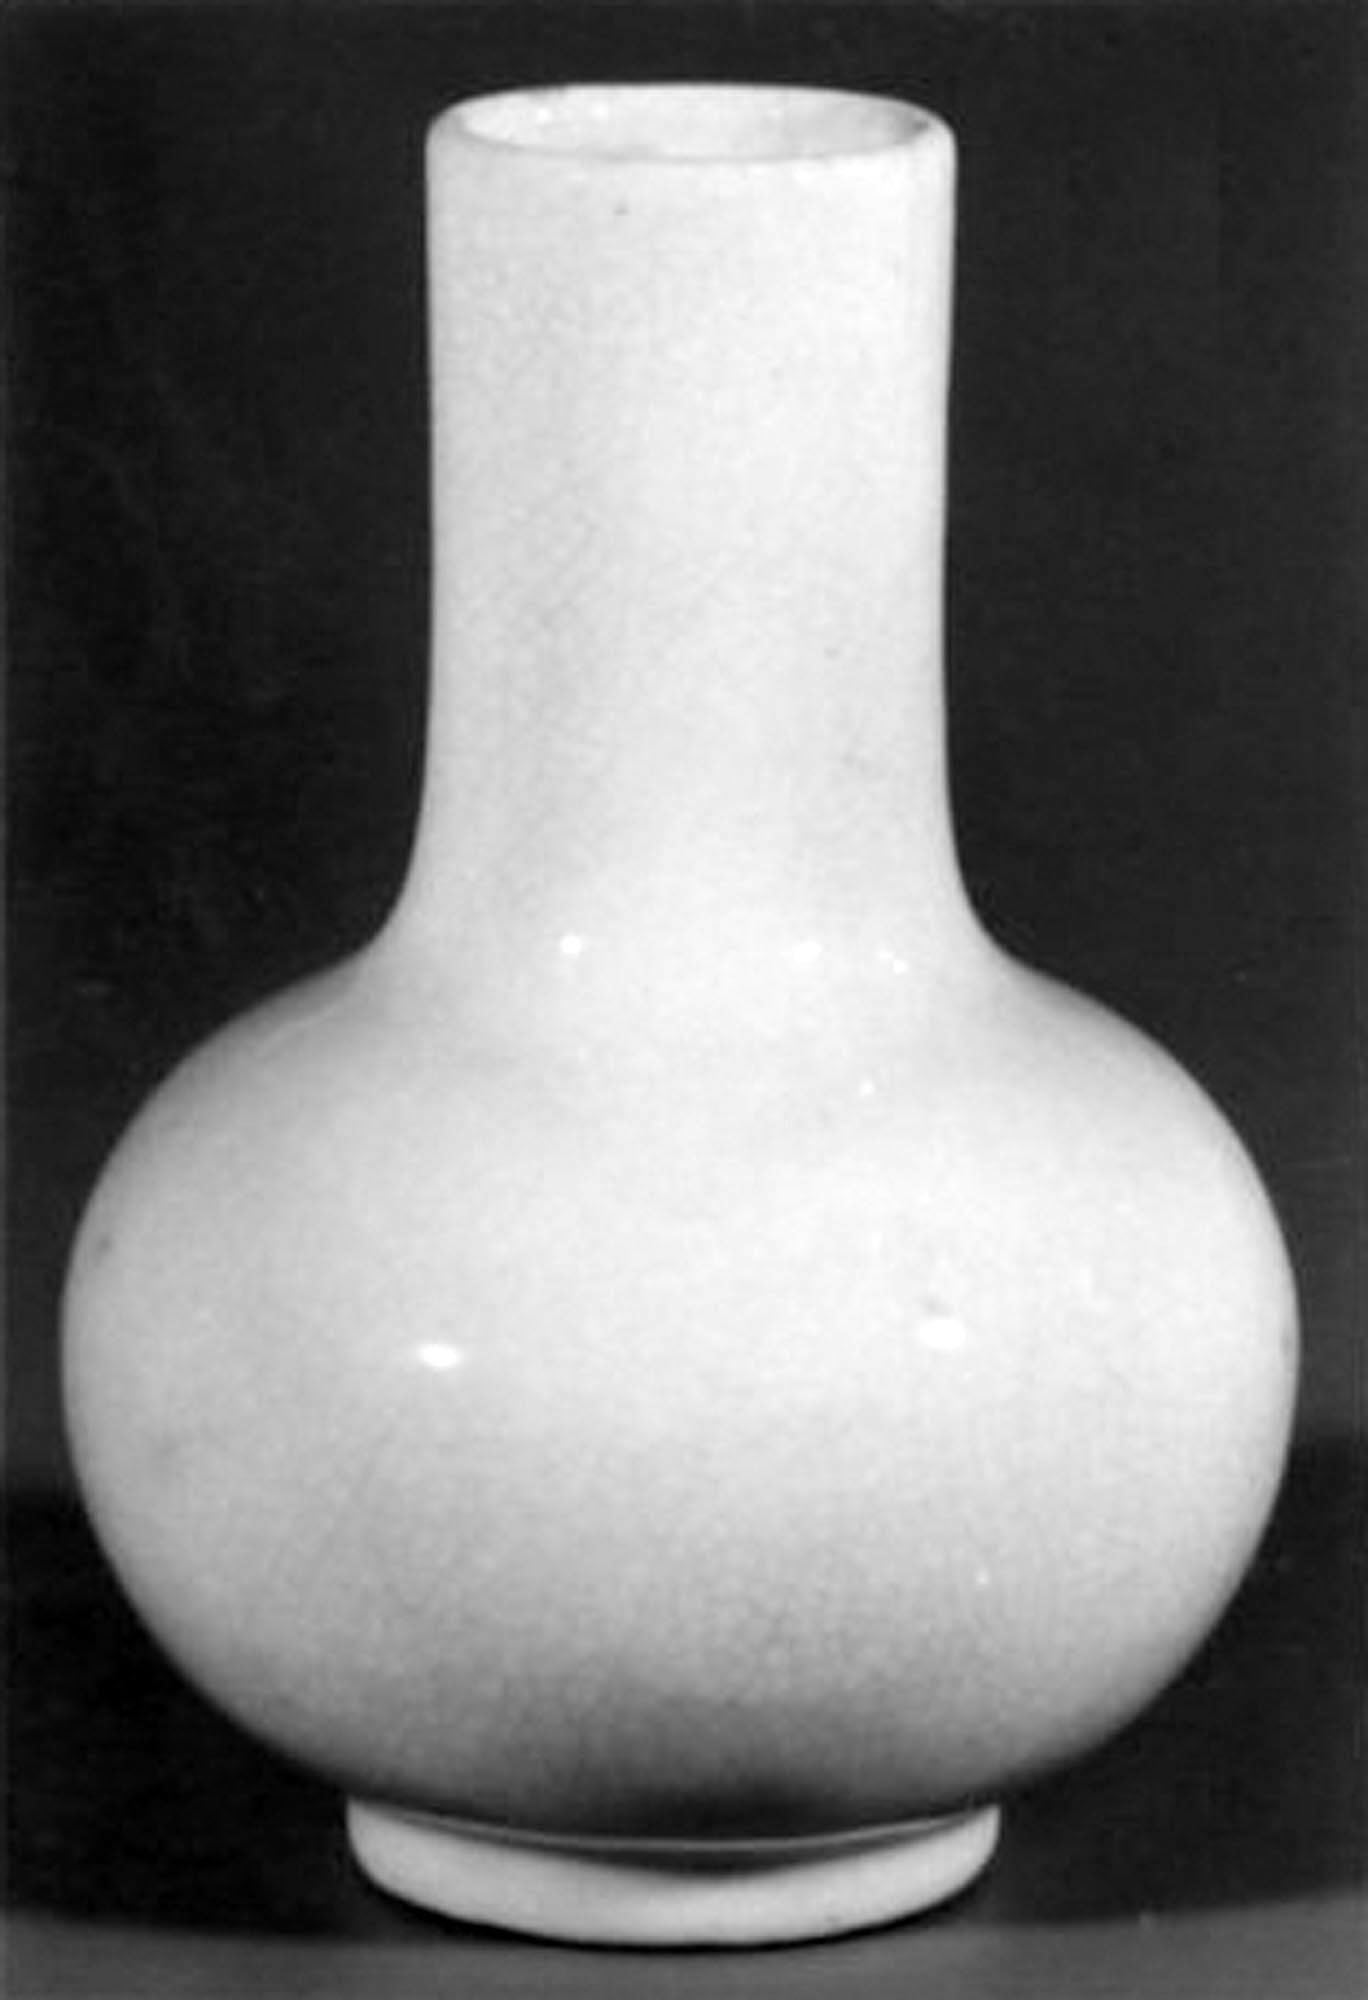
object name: vase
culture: chinese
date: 1736-1795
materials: glaze, porcelain